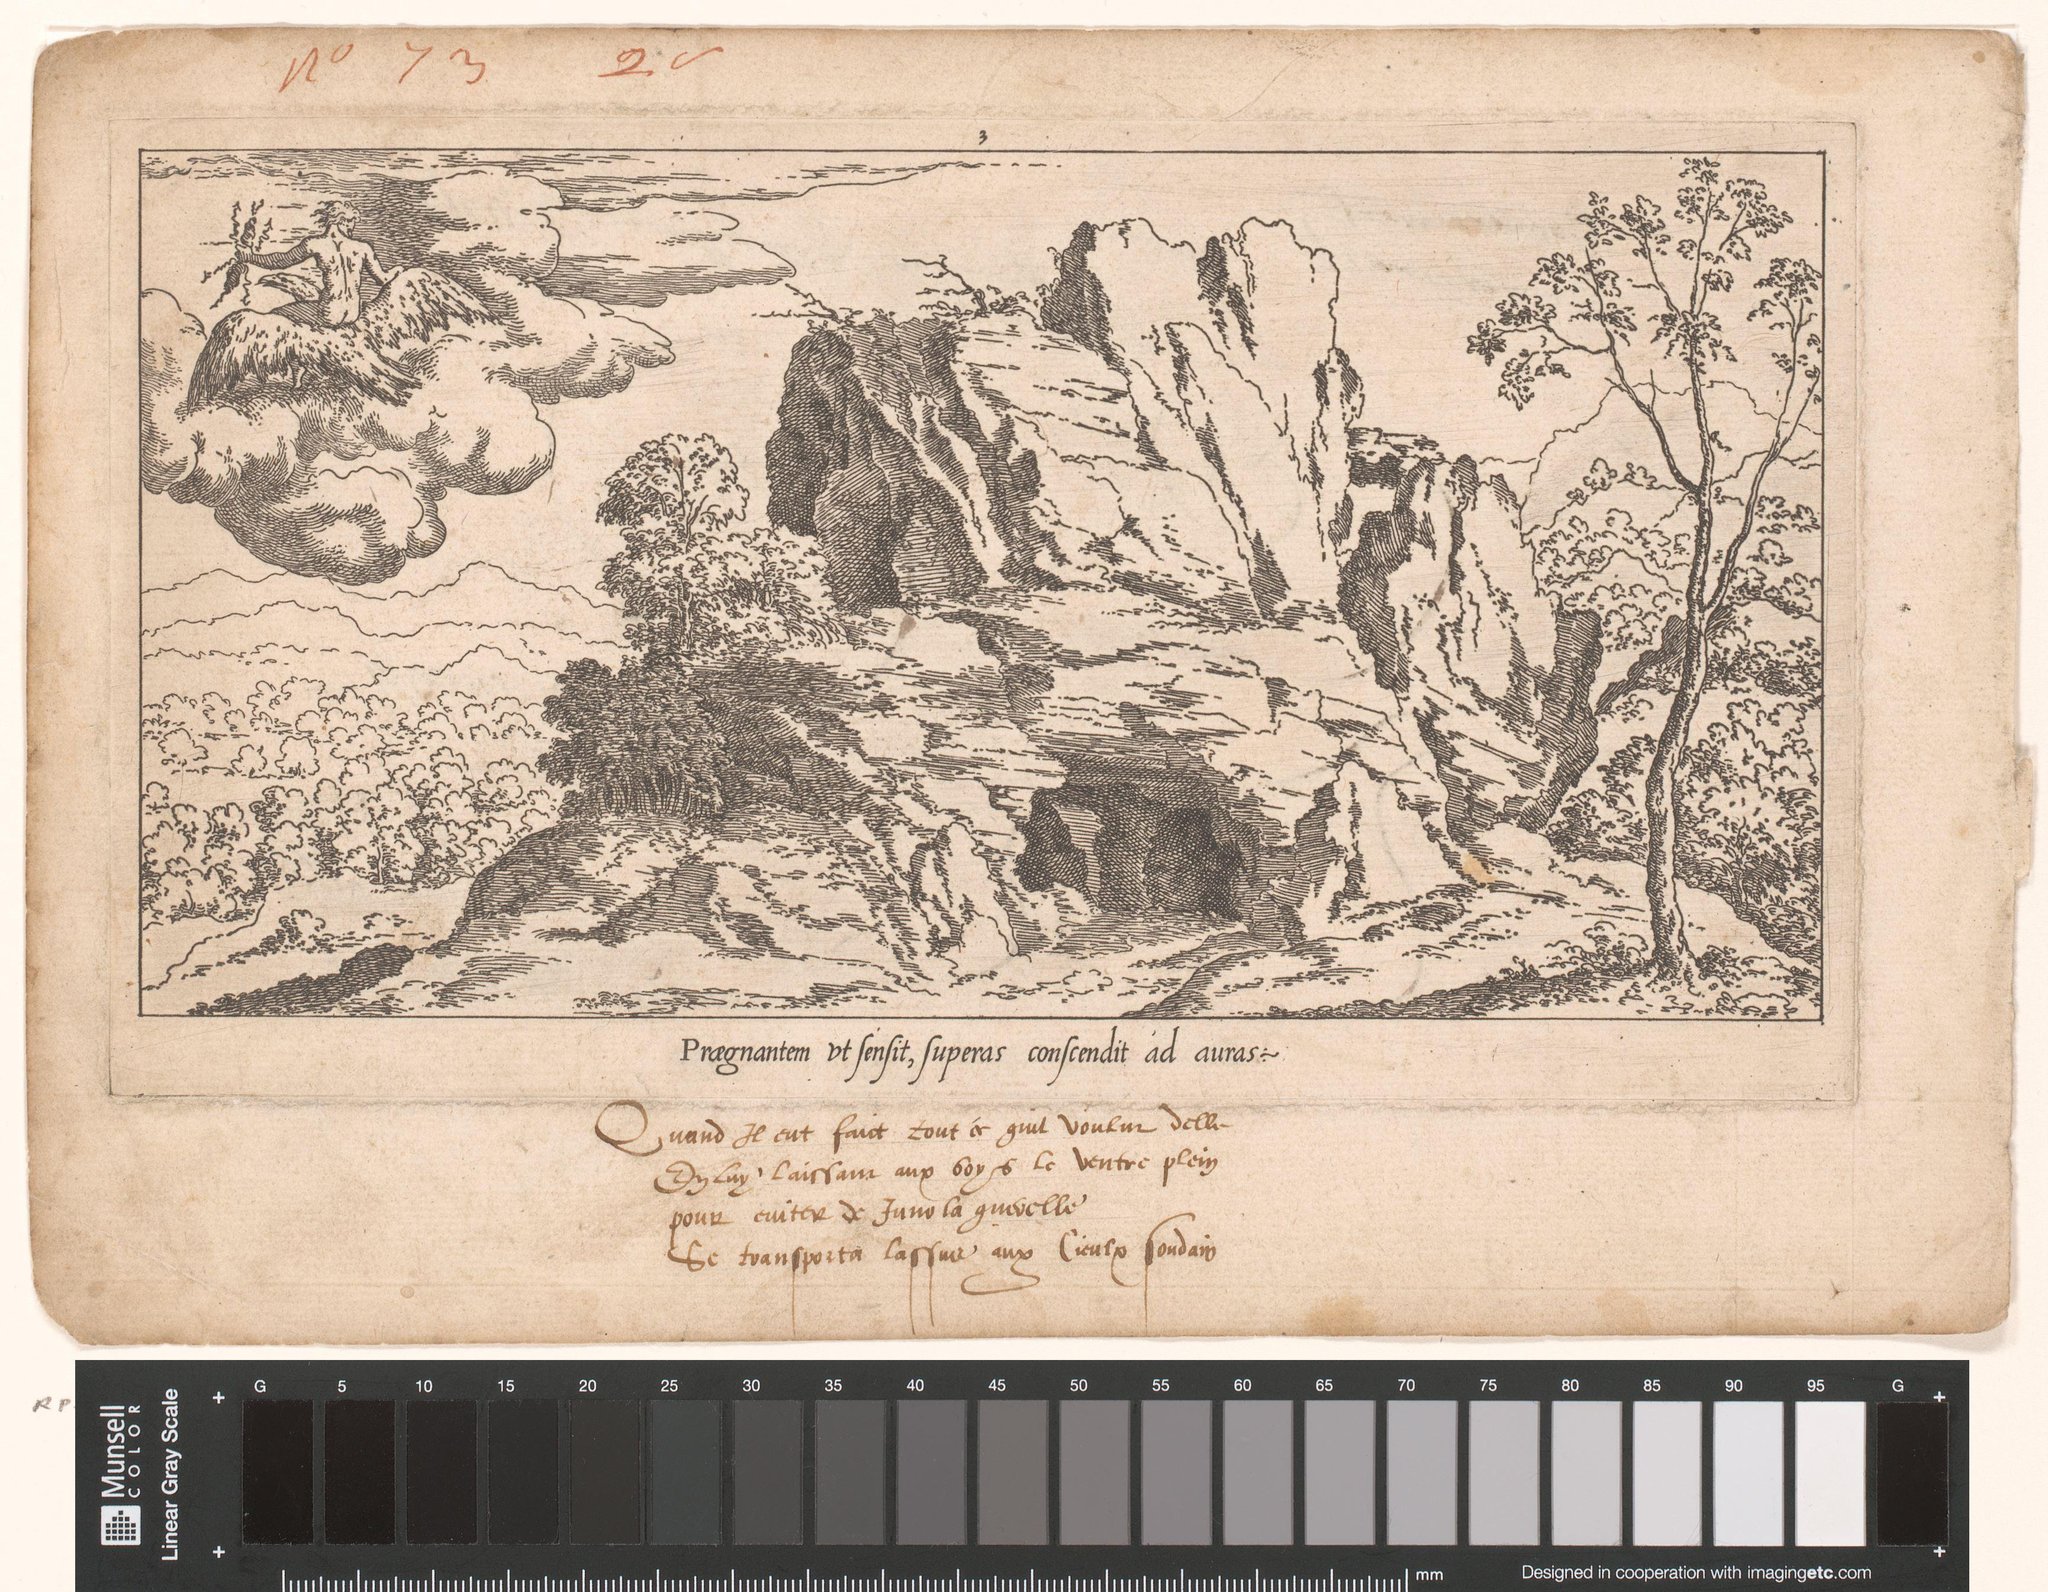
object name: print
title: Le Fable de Calisto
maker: léon davent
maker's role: print maker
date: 1547-1550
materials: paper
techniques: etching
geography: france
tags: (story of) jupiter (zeus)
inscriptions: inscription:, collector's mark: Lugt 2228, inscription: ‘Quand il cut faict tout á guil voulez della/ celuy laissan aux le ventre plein/ pour eviter de Juno la guivelle/ de transporta lassure aux cieuls soudain.’, collector's mark: Lugt 2760, number: ‘No 73 2v’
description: Landschap met rots en grotten. Linksboven is Jupiter gezeten op een adelaar zichtbaar in een wolkenpartij. In zijn linkerhand houdt hij drie bliksemschichten vast. Rechtsvoor staat een jonge loofboom.